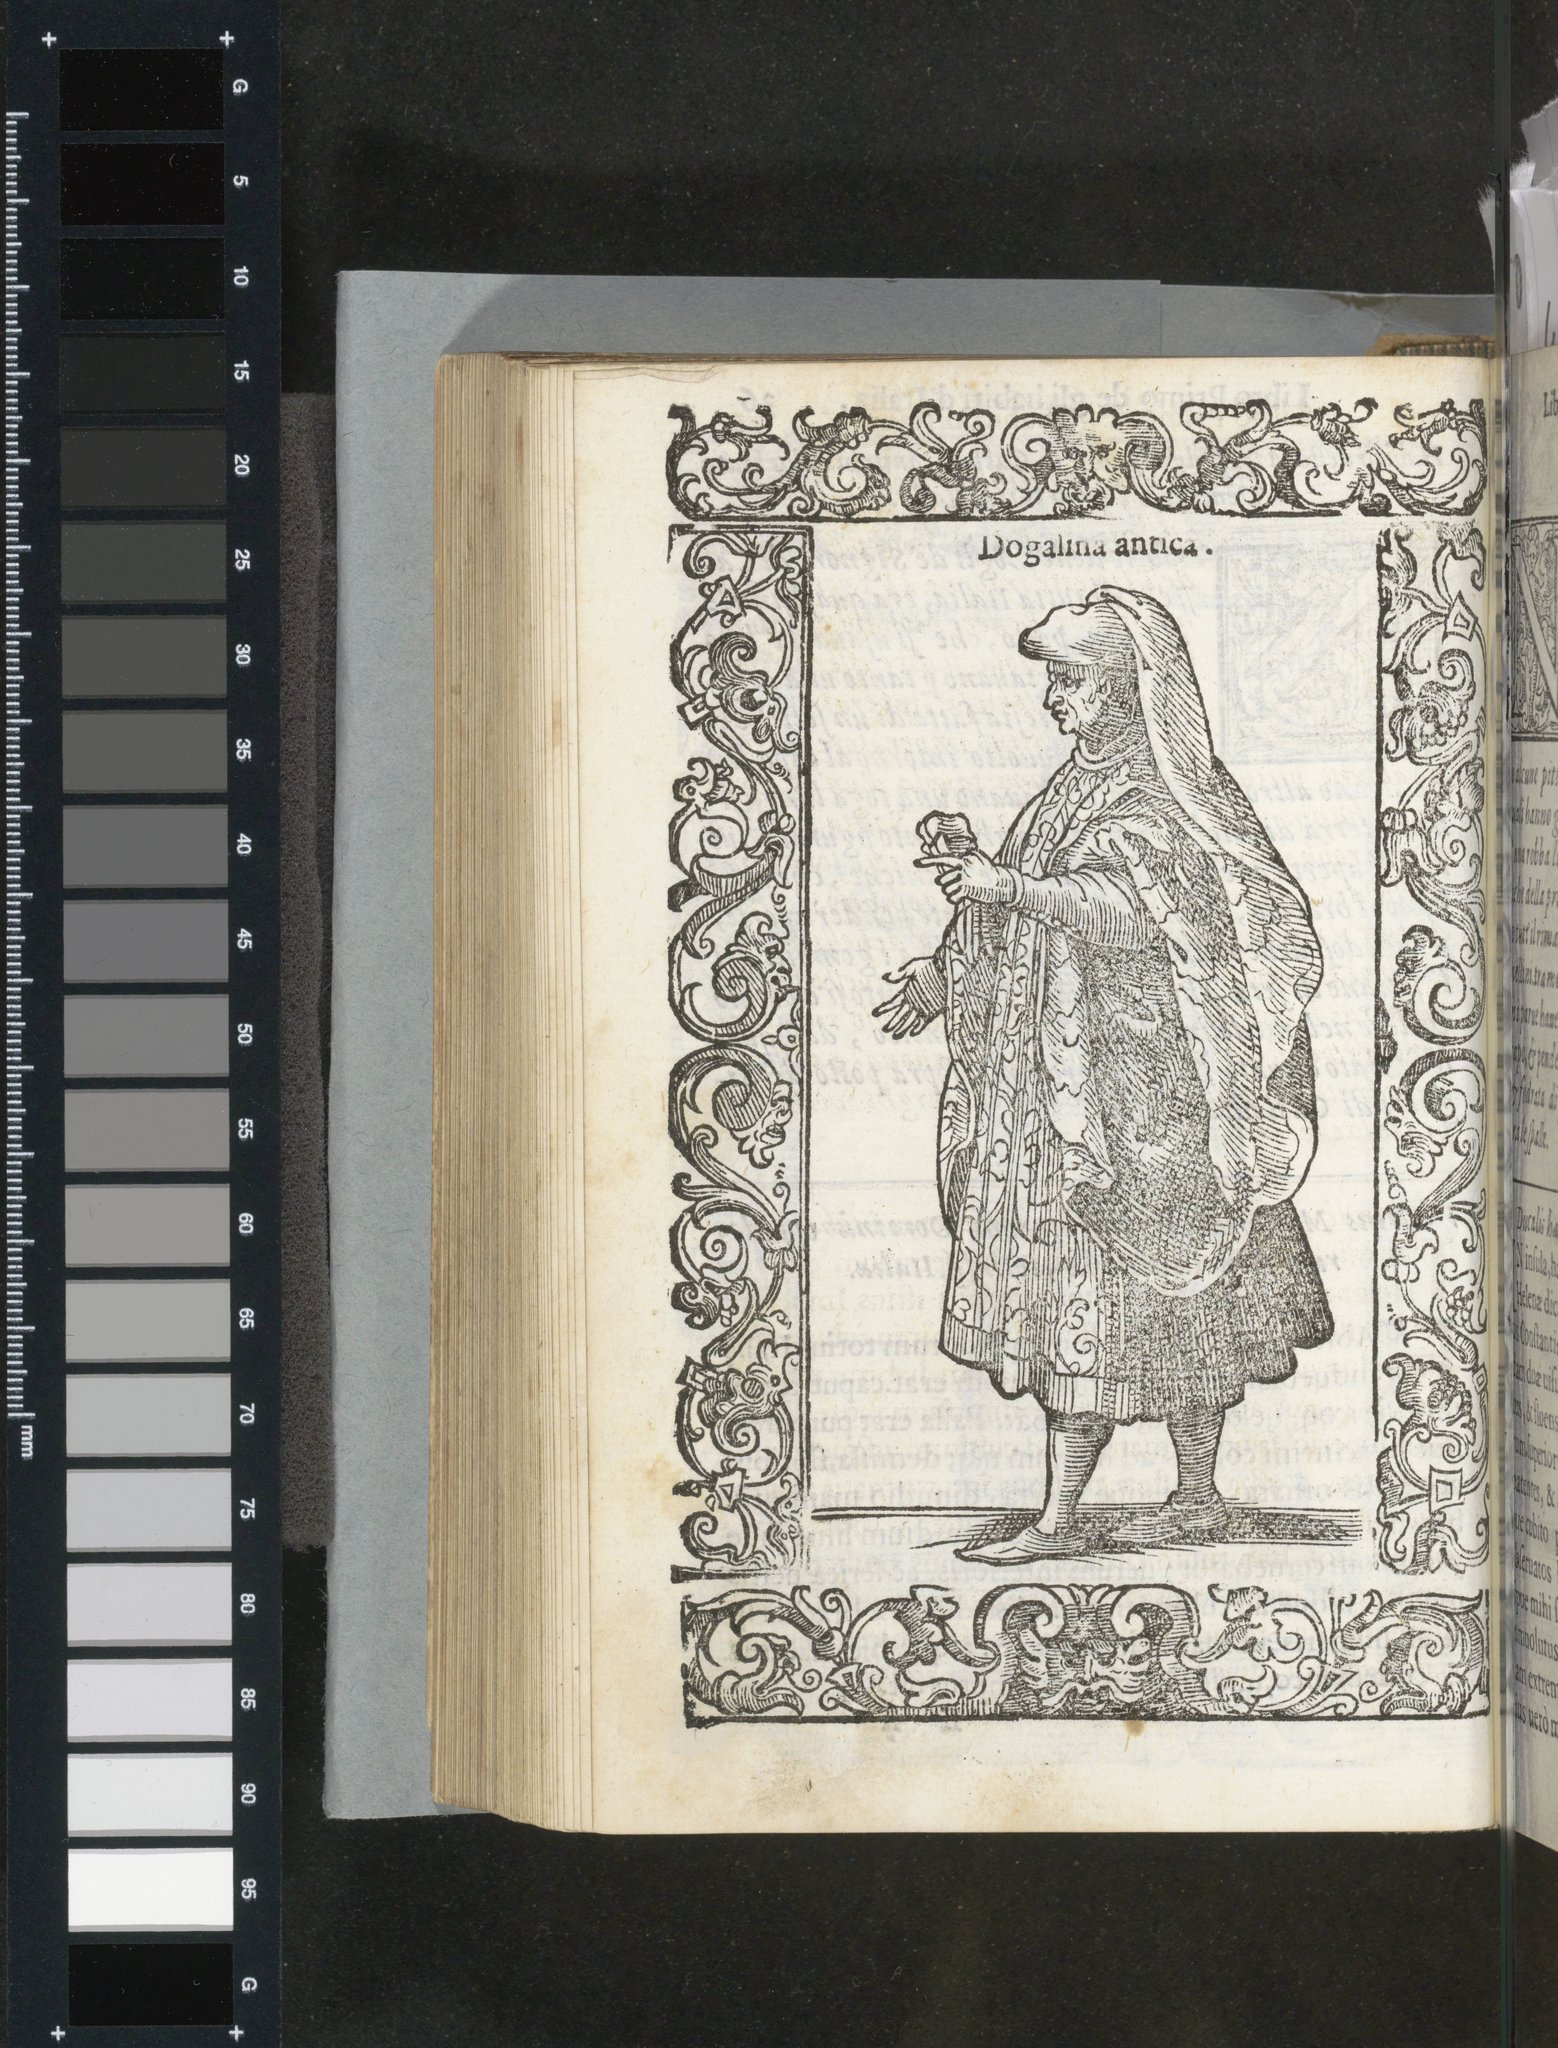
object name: costume print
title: Habiti antichi, et moderni di tutto il mondo : di nuovo accresciuti di molte figure : vestitus antiquorum, recentiorumque totius orbis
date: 1598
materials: paper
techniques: woodcut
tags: fashion plates